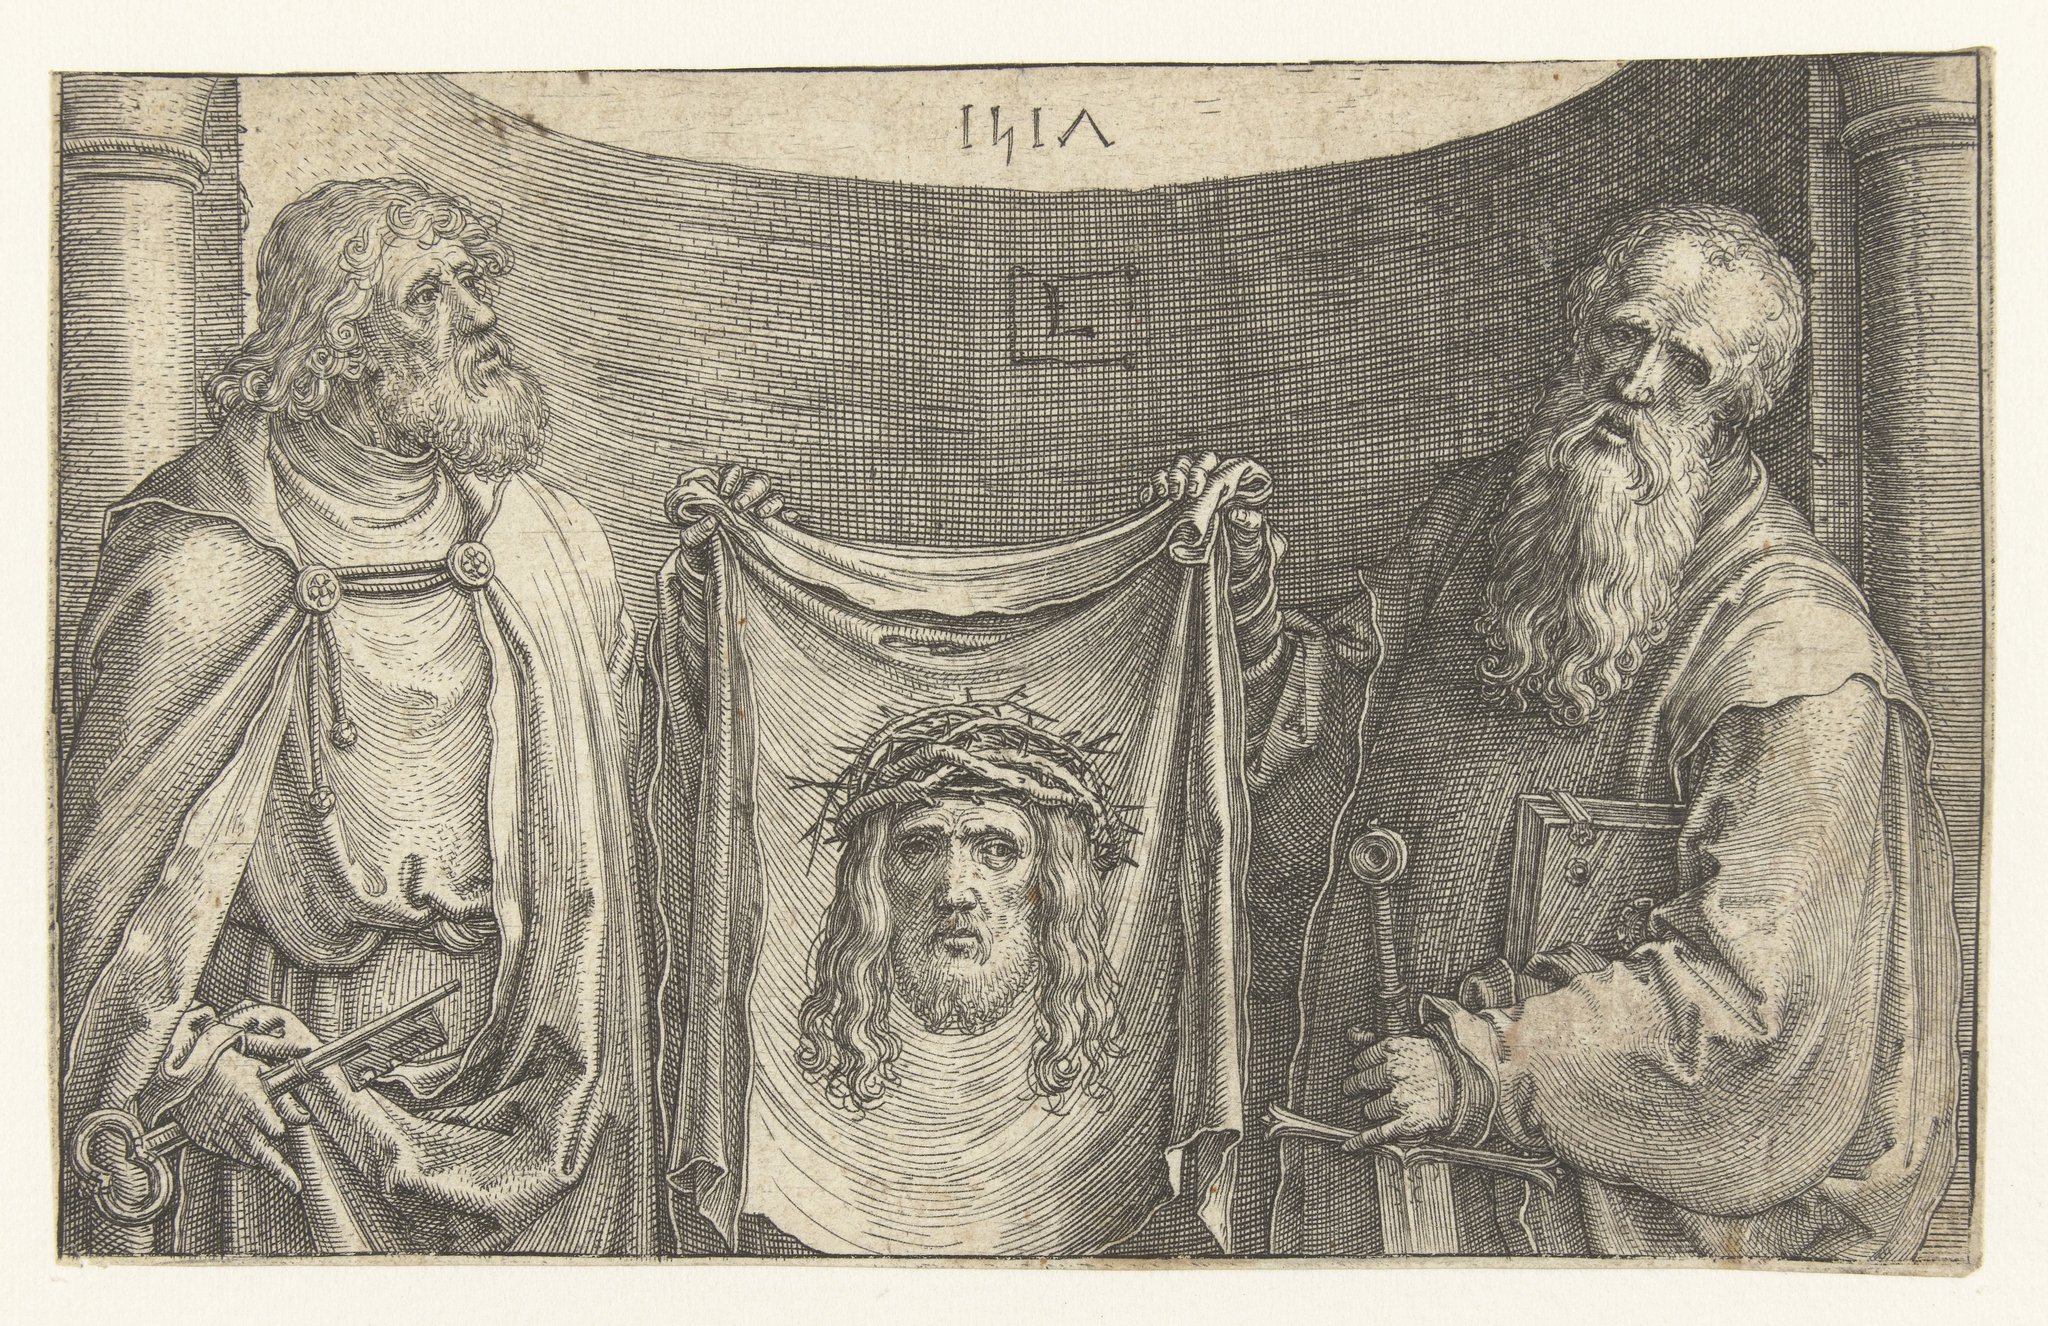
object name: print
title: Petrus en Paulus met het Sudarium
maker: lucas van leyden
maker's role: draughtsman, painter, print maker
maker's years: 1494-1533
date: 1517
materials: paper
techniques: engraving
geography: low countries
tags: 'vera icon', held up by peter and paul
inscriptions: collector's mark: Lugt 240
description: Petrus en Paulus ten halven lijve, zweetdoek vasthoudend met een afbeelding van het hoofd van Christus met doornenkroon.